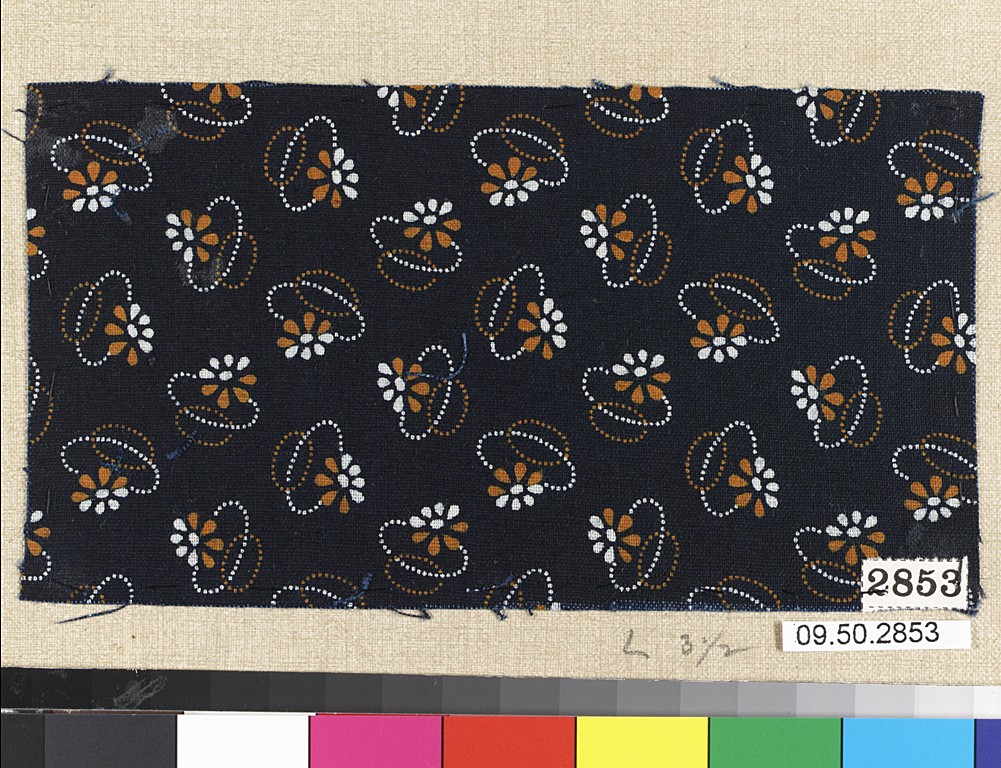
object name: piece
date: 1801-1900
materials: cotton